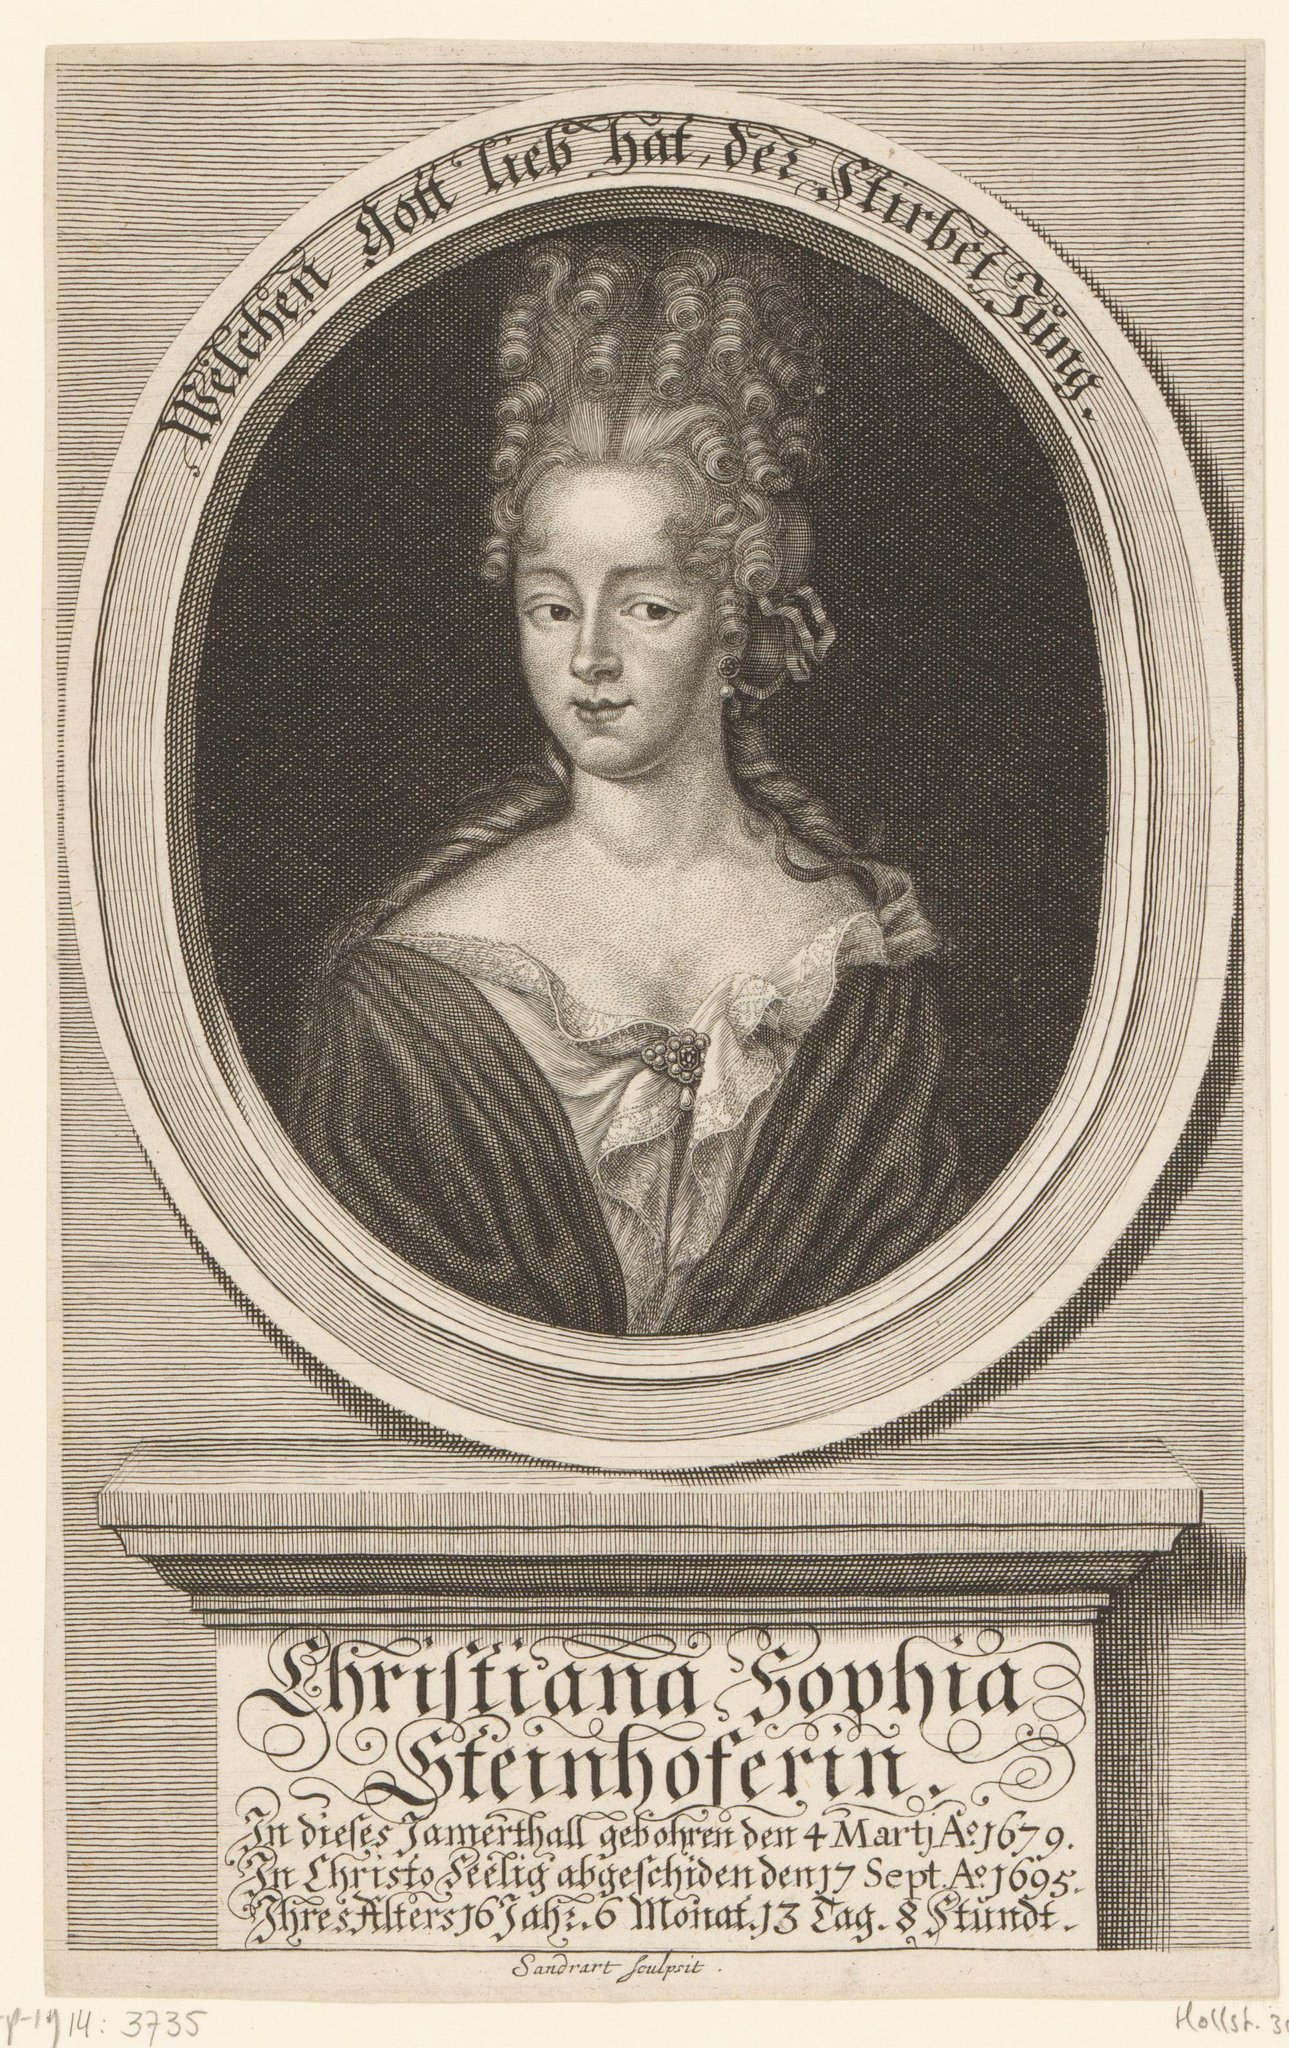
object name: print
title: Portret van Christiana Sophia Steinhofer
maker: jakob von sandrart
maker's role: print maker, publisher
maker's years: 1630-1708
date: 1695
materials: paper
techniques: engraving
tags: historical persons - bb - woman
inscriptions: collector's mark: Lugt 2228